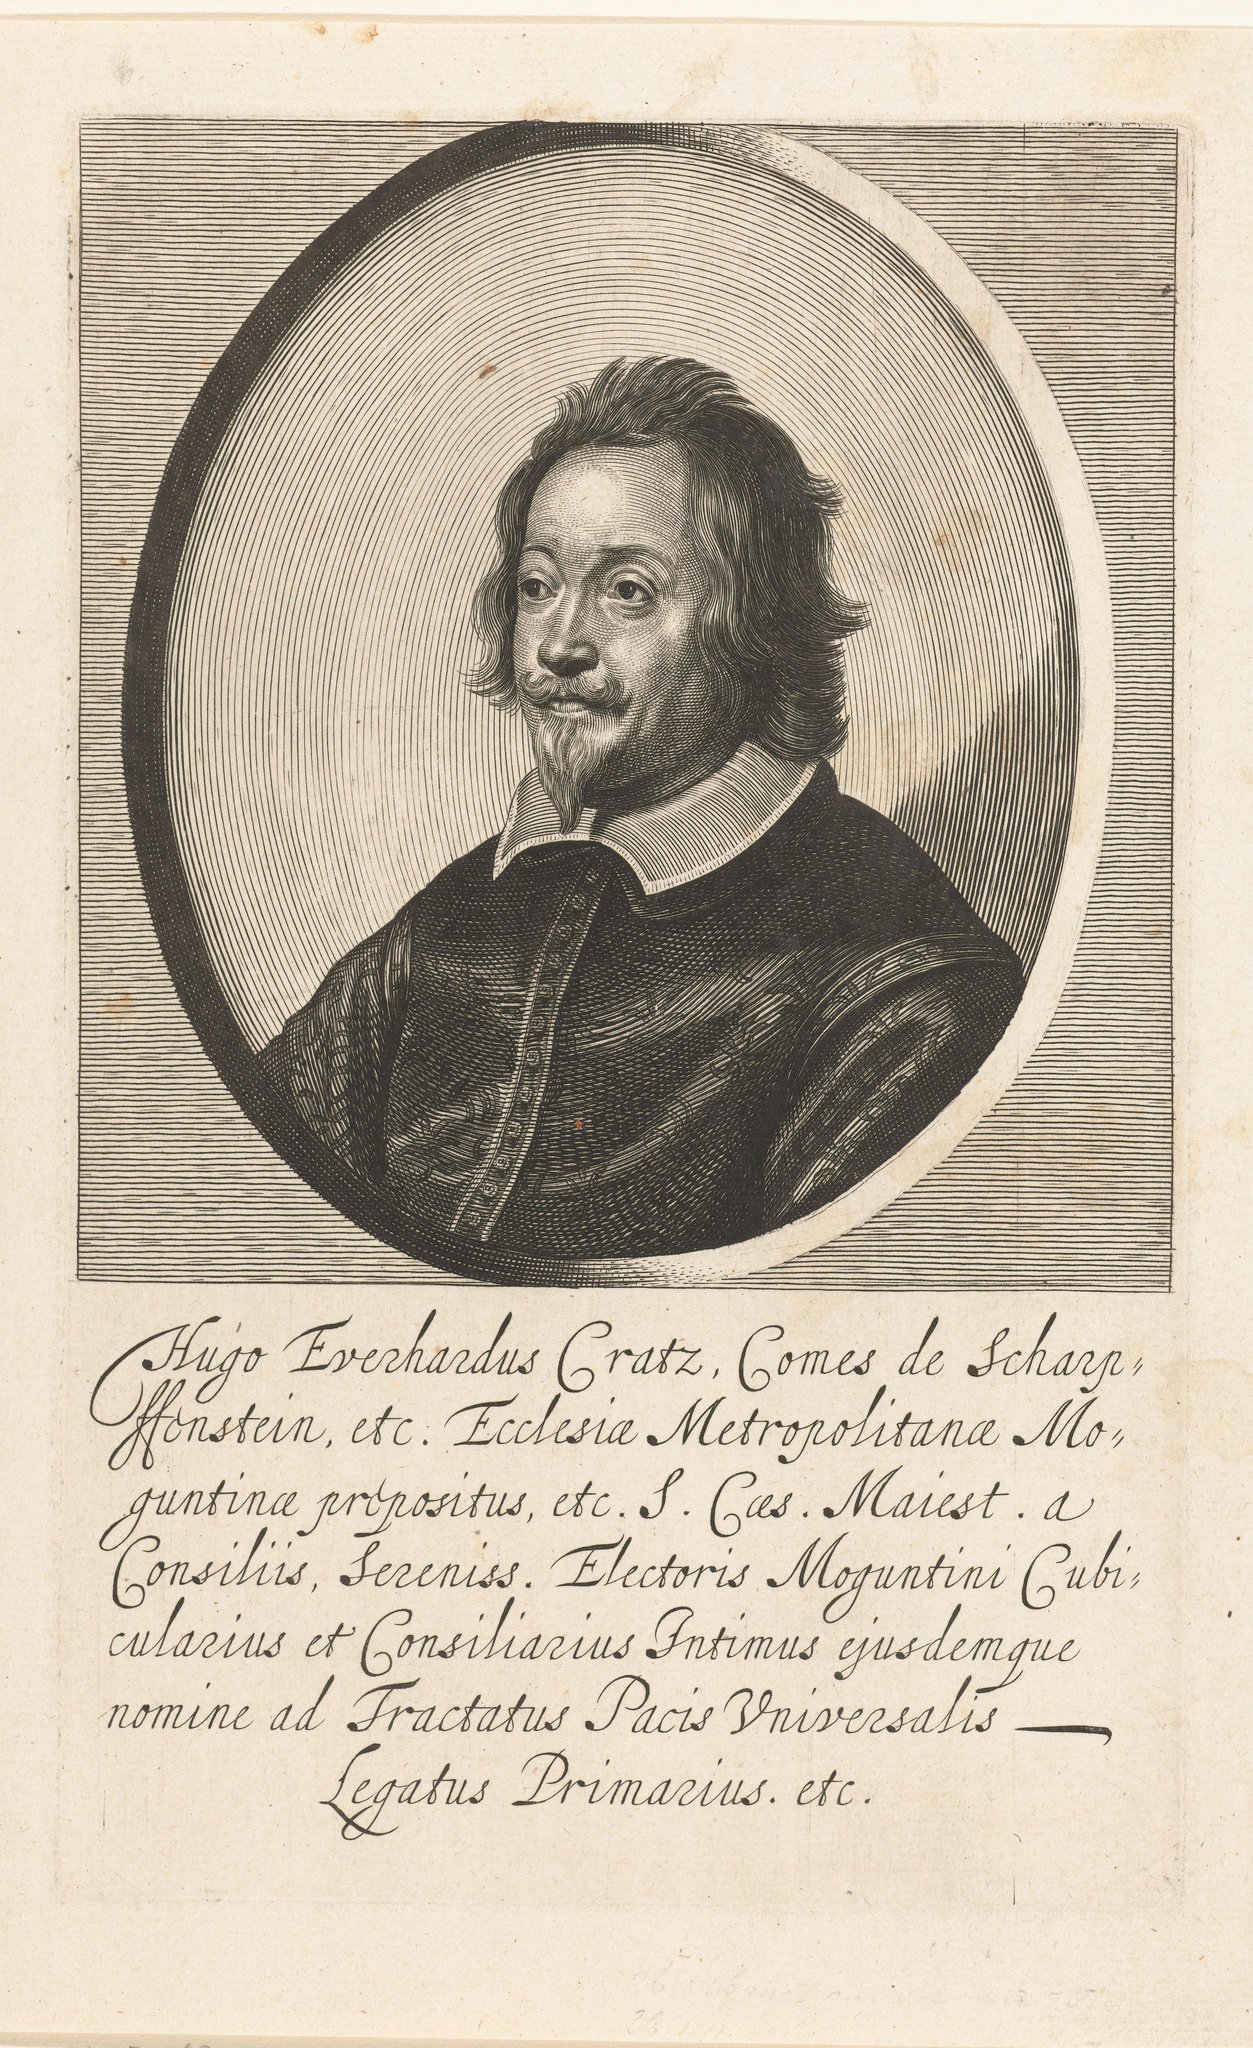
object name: print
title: Hugo Everhardus Cratz (...) legatus Primarius etc.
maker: pieter de bailliu (i)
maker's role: print maker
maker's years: 1613-1660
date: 1623-1660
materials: paper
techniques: engraving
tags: regensburg, bisschop, diplomaat, hugo everhard cratz (graaf van scharfenstein)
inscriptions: collector's mark: Lugt 240